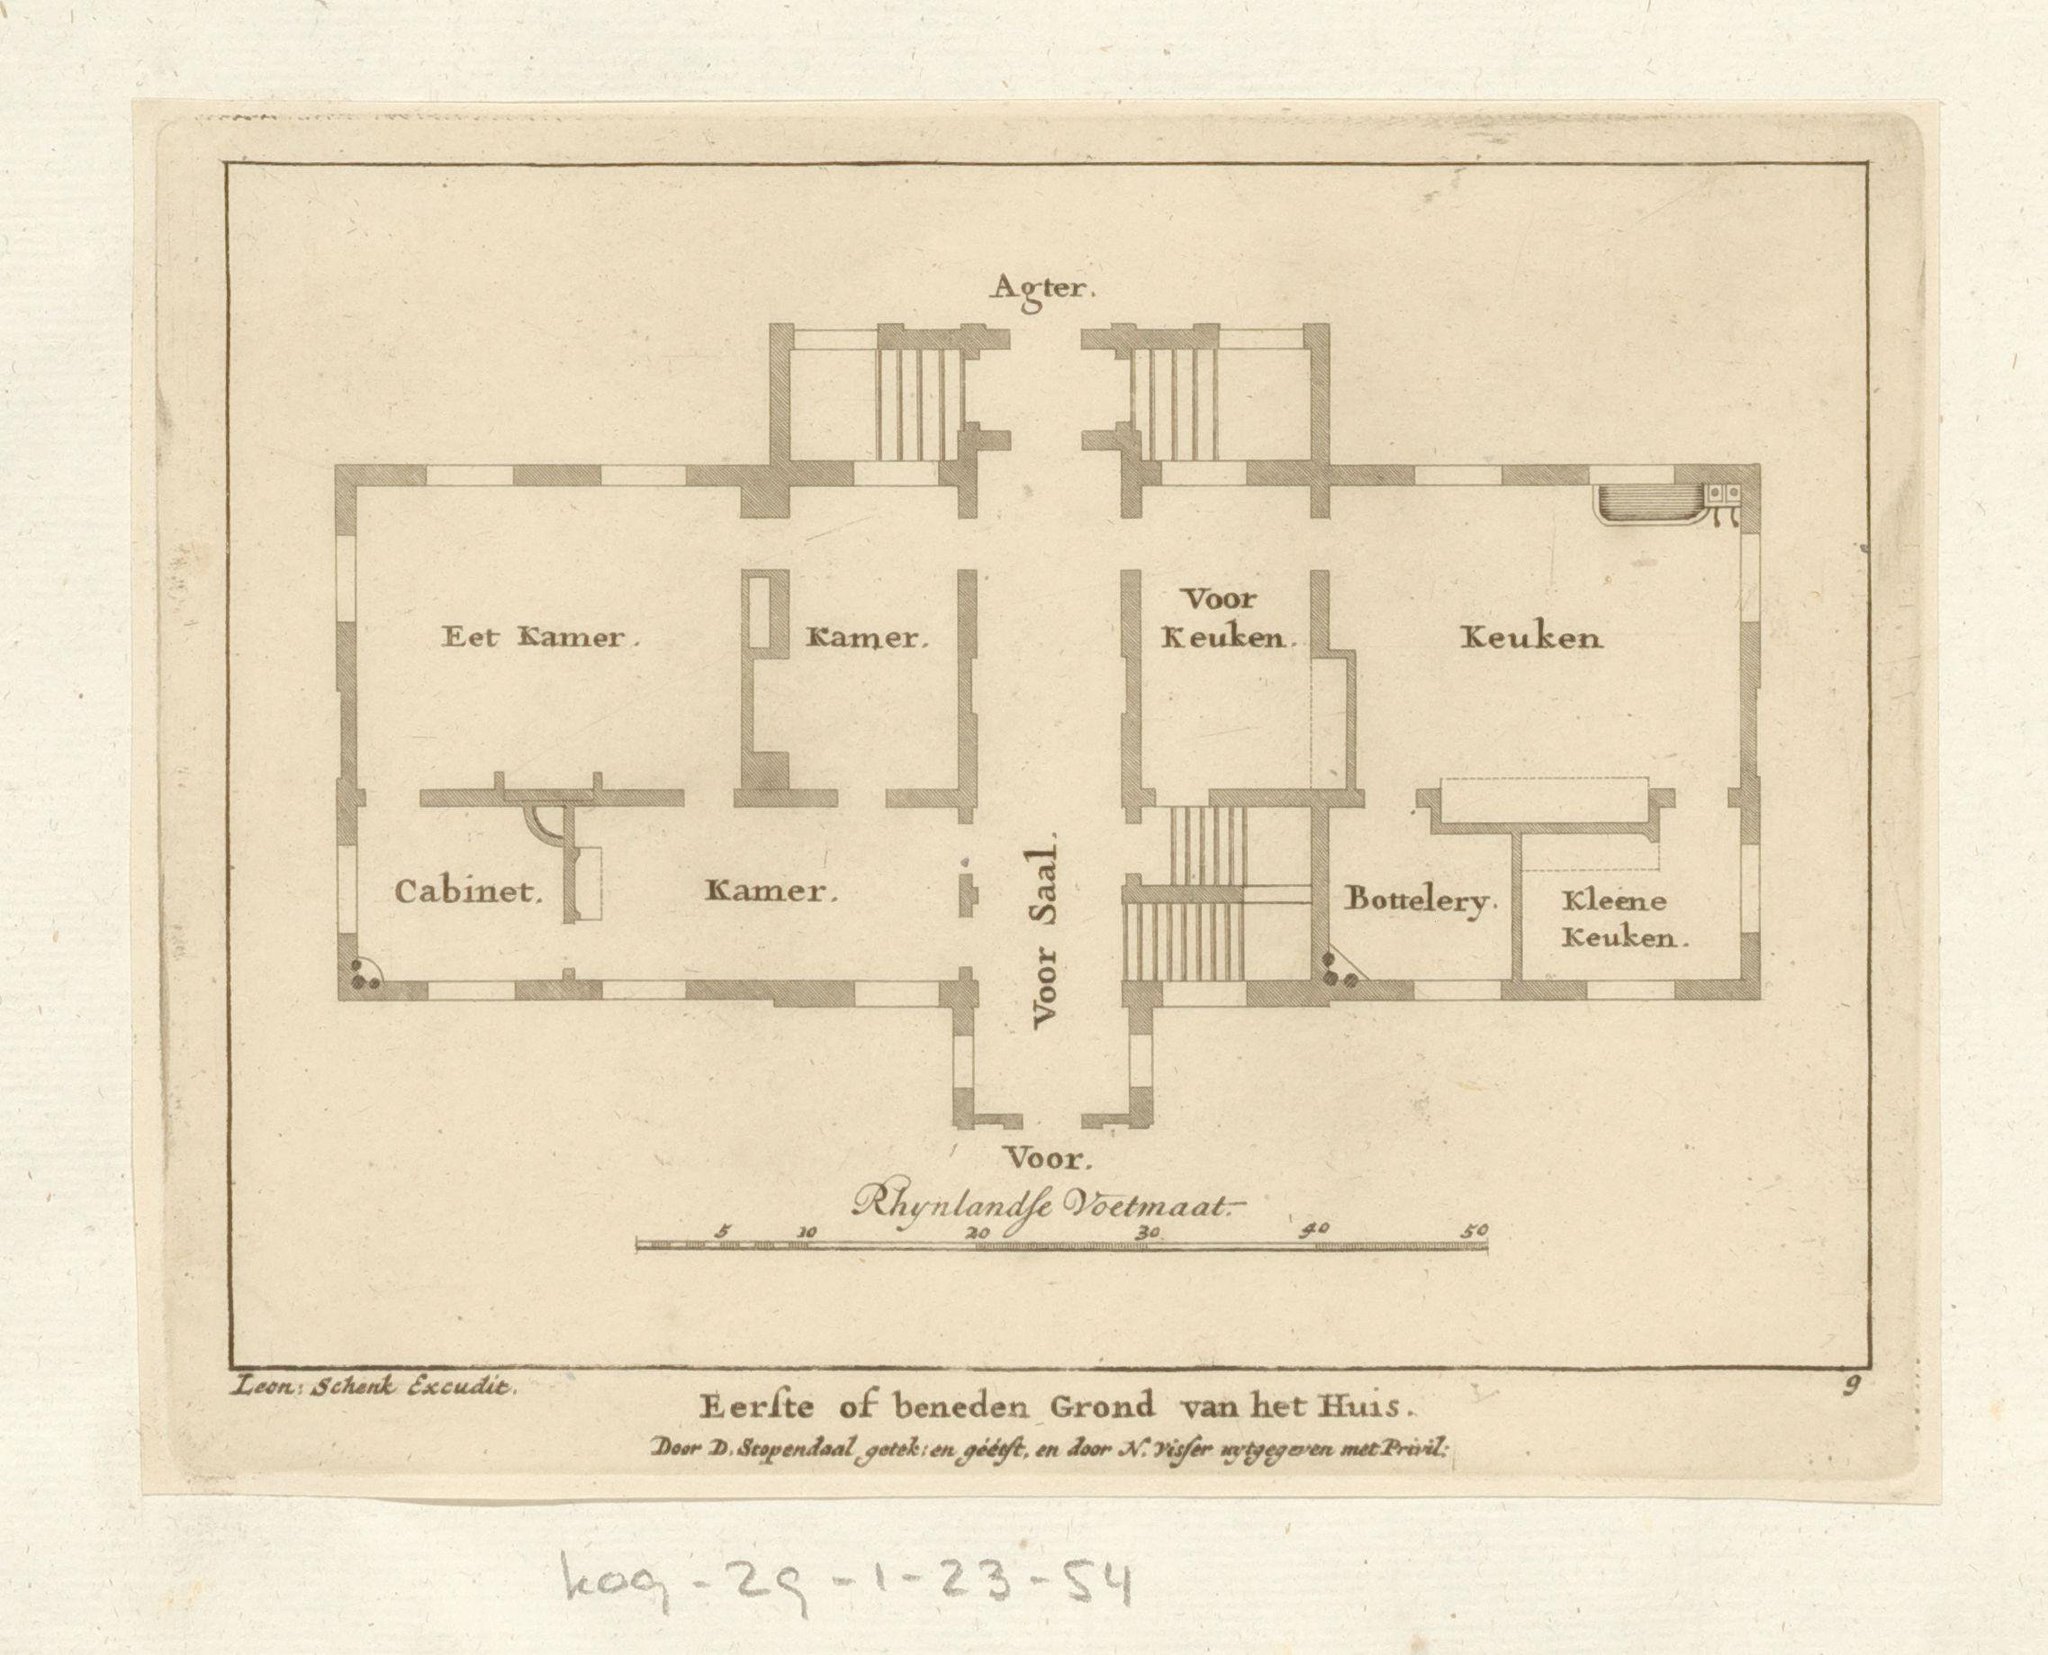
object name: print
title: Plattegrond van de begane grond van Huis Clingendael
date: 1706-1767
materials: paper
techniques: engraving, etching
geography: amsterdam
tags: plan ~ architecture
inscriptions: collector's mark: Lugt 1641, stamp, stamp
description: Plattegrond van de begane grond van Huis Clingendael. Onderaan een schaalverdeling. Onderwerpsrubrieken binnen de Atlas Zeden en Gewoonten: Zeden en Gewoonten in Engeren Zin, De Woning. Kastelen en buitenplaatsen. Holland.